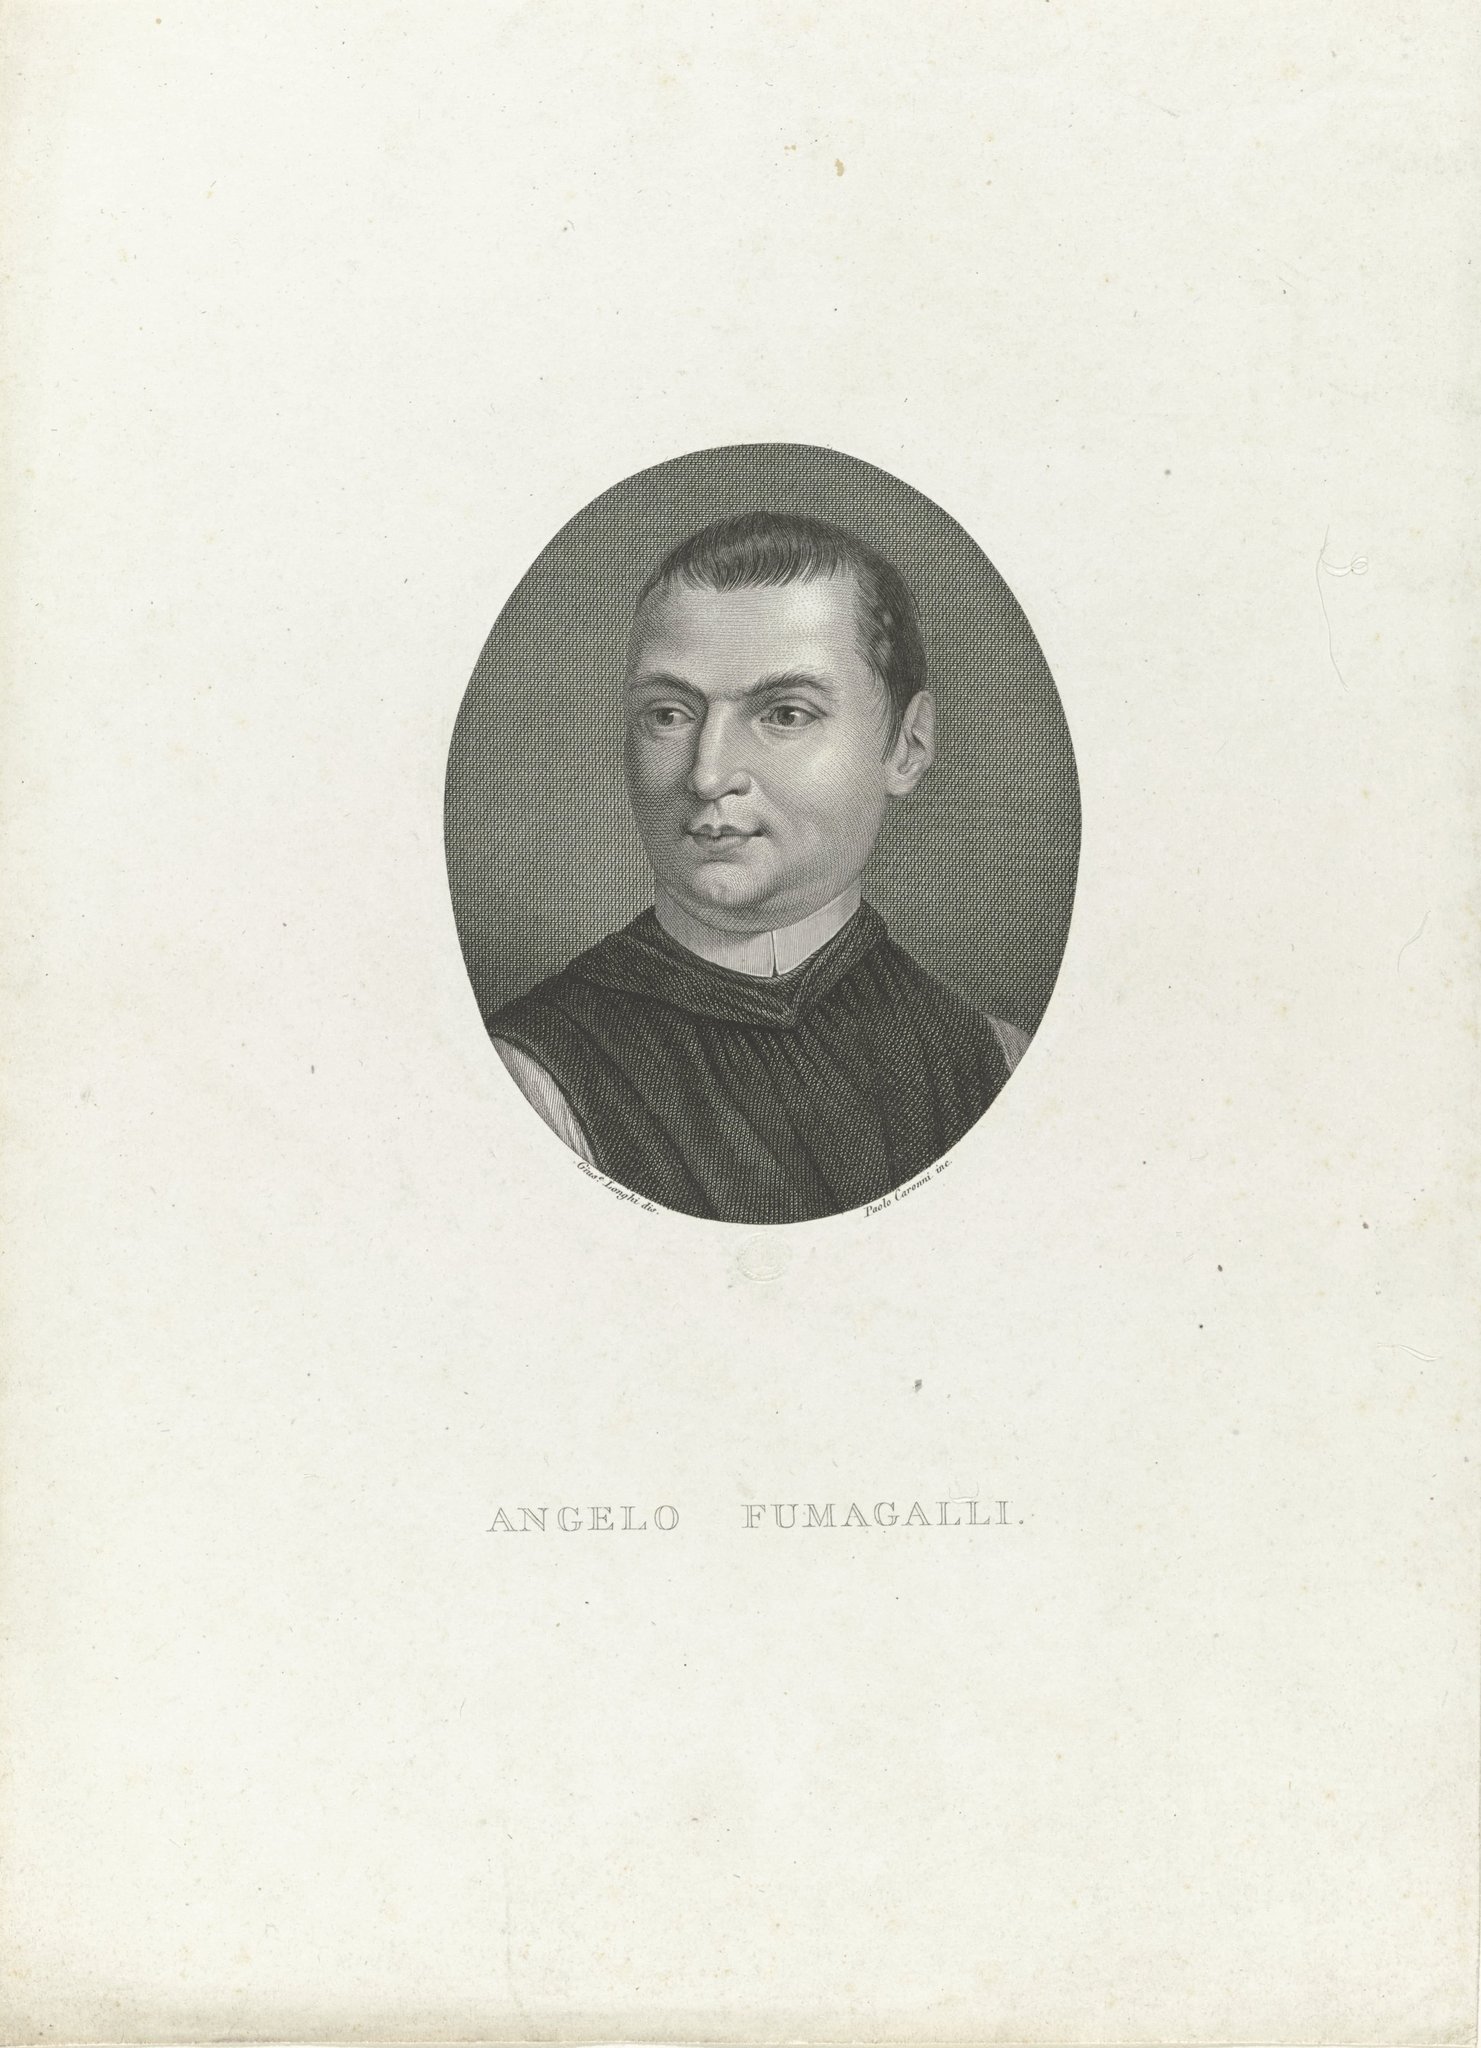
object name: print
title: Portret van abt Angelo Fumagali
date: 1789-1842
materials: paper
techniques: engraving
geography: italy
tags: abbot, historical persons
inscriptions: collector's mark: Lugt 2228, collector's mark: Lugt 4187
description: Deze prent maakt deel uit van een reeks portretprenten van onbekende omvang. De reeks is in meerdere staten uitgegeven. De eerste staat met enkel het portret in ovaal. Een tweede staat met naam van de geportretteerde in holle letters onder de voorstelling. Een derde staat met de naam van de geportretteerde in gevulde letters onder de voorstelling. En een vierde staat met een rechthoekig kader rondom het ovale portret.